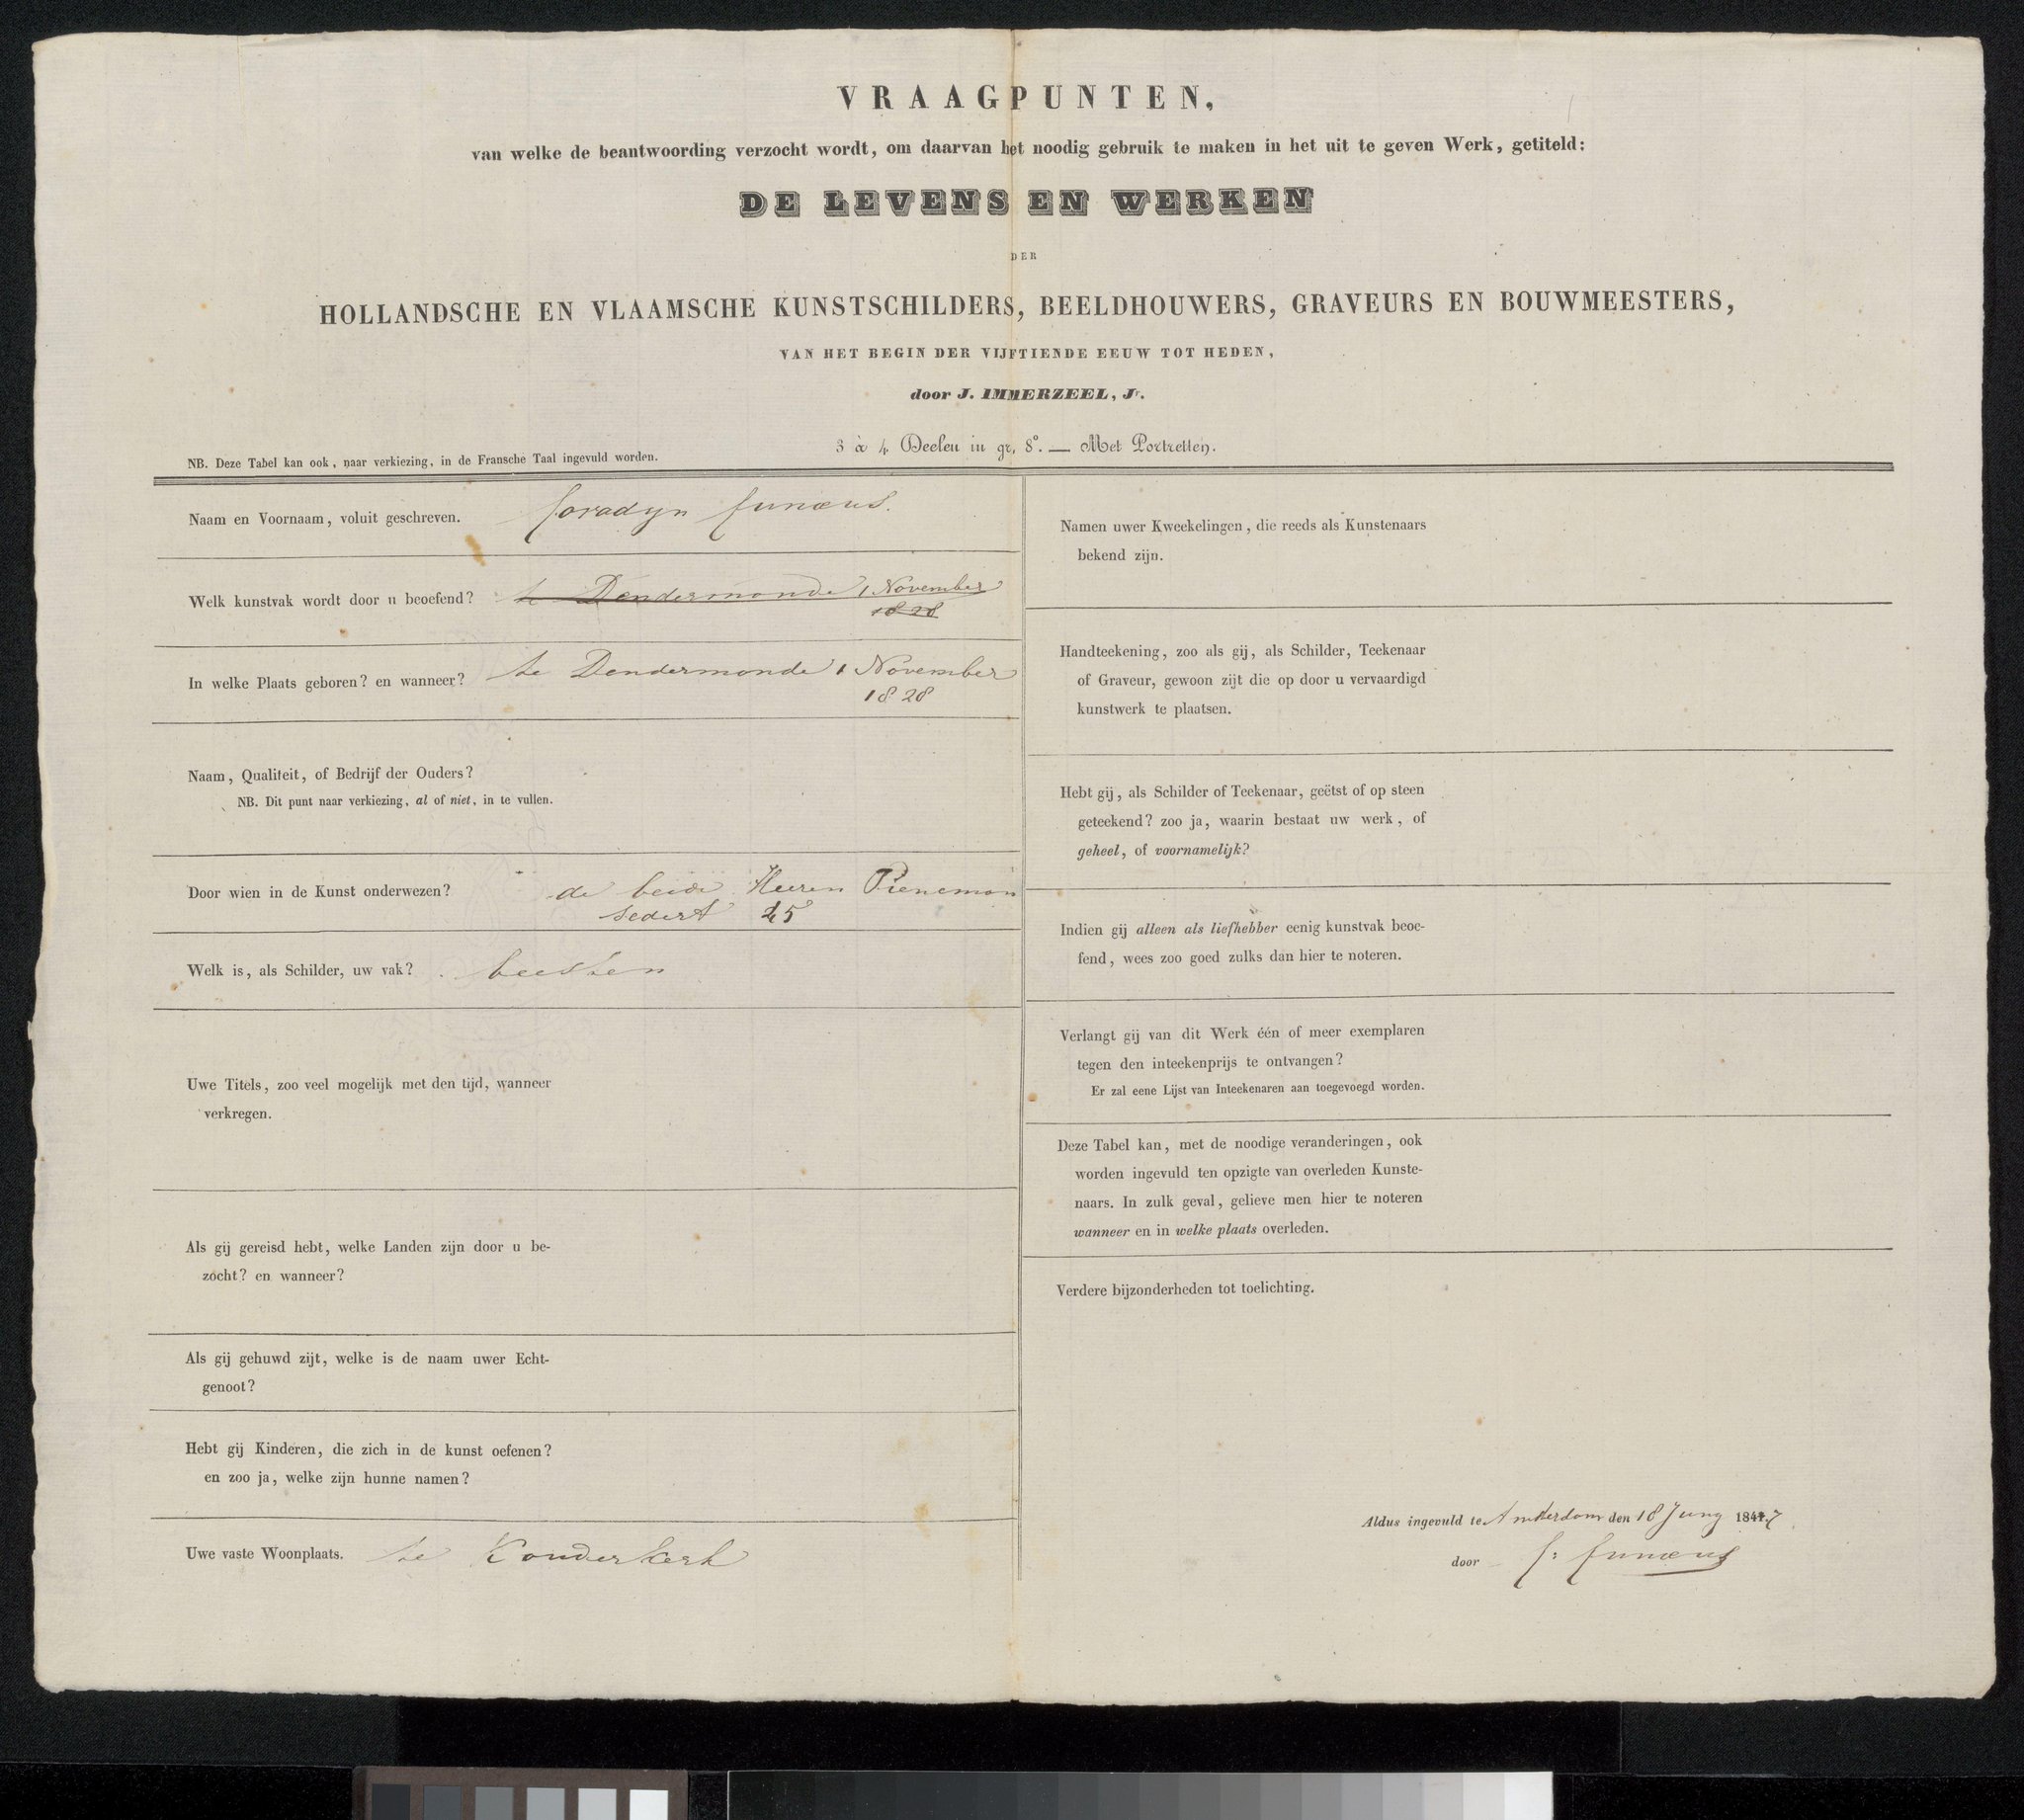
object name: questionnaire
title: Enquêteformulier ingevuld door Conradijn Cunaeus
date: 1847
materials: ink, paper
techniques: pen, printing, writing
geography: amsterdam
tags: draughtsman, conradijn cunaeus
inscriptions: inscription: ‘Vraagpunten,/ van welke de beantwoording verzocht wordt, om daarvan het noodig gebruik te maken in het uit te geven Werk, getiteld: De levens en werken/ der Hollandsche en Vlaamsche kunstschilders, beeldhouwers,/ graveurs en bouwmeesters, van het begin der vijftiende eeuw tot heden/ door J. Immerzeel, Jr.’, watermark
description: Bedoeld voor: Immerzeel, J. Jr., De levens en werken der Hollandsche en Vlaamsche kunstschilders, beeldhouwers, graveurs en bouwmeesters, van het begin der vijftiende eeuw tot heden, Amsterdam: J.C. van Kesteren, 1842-1843.